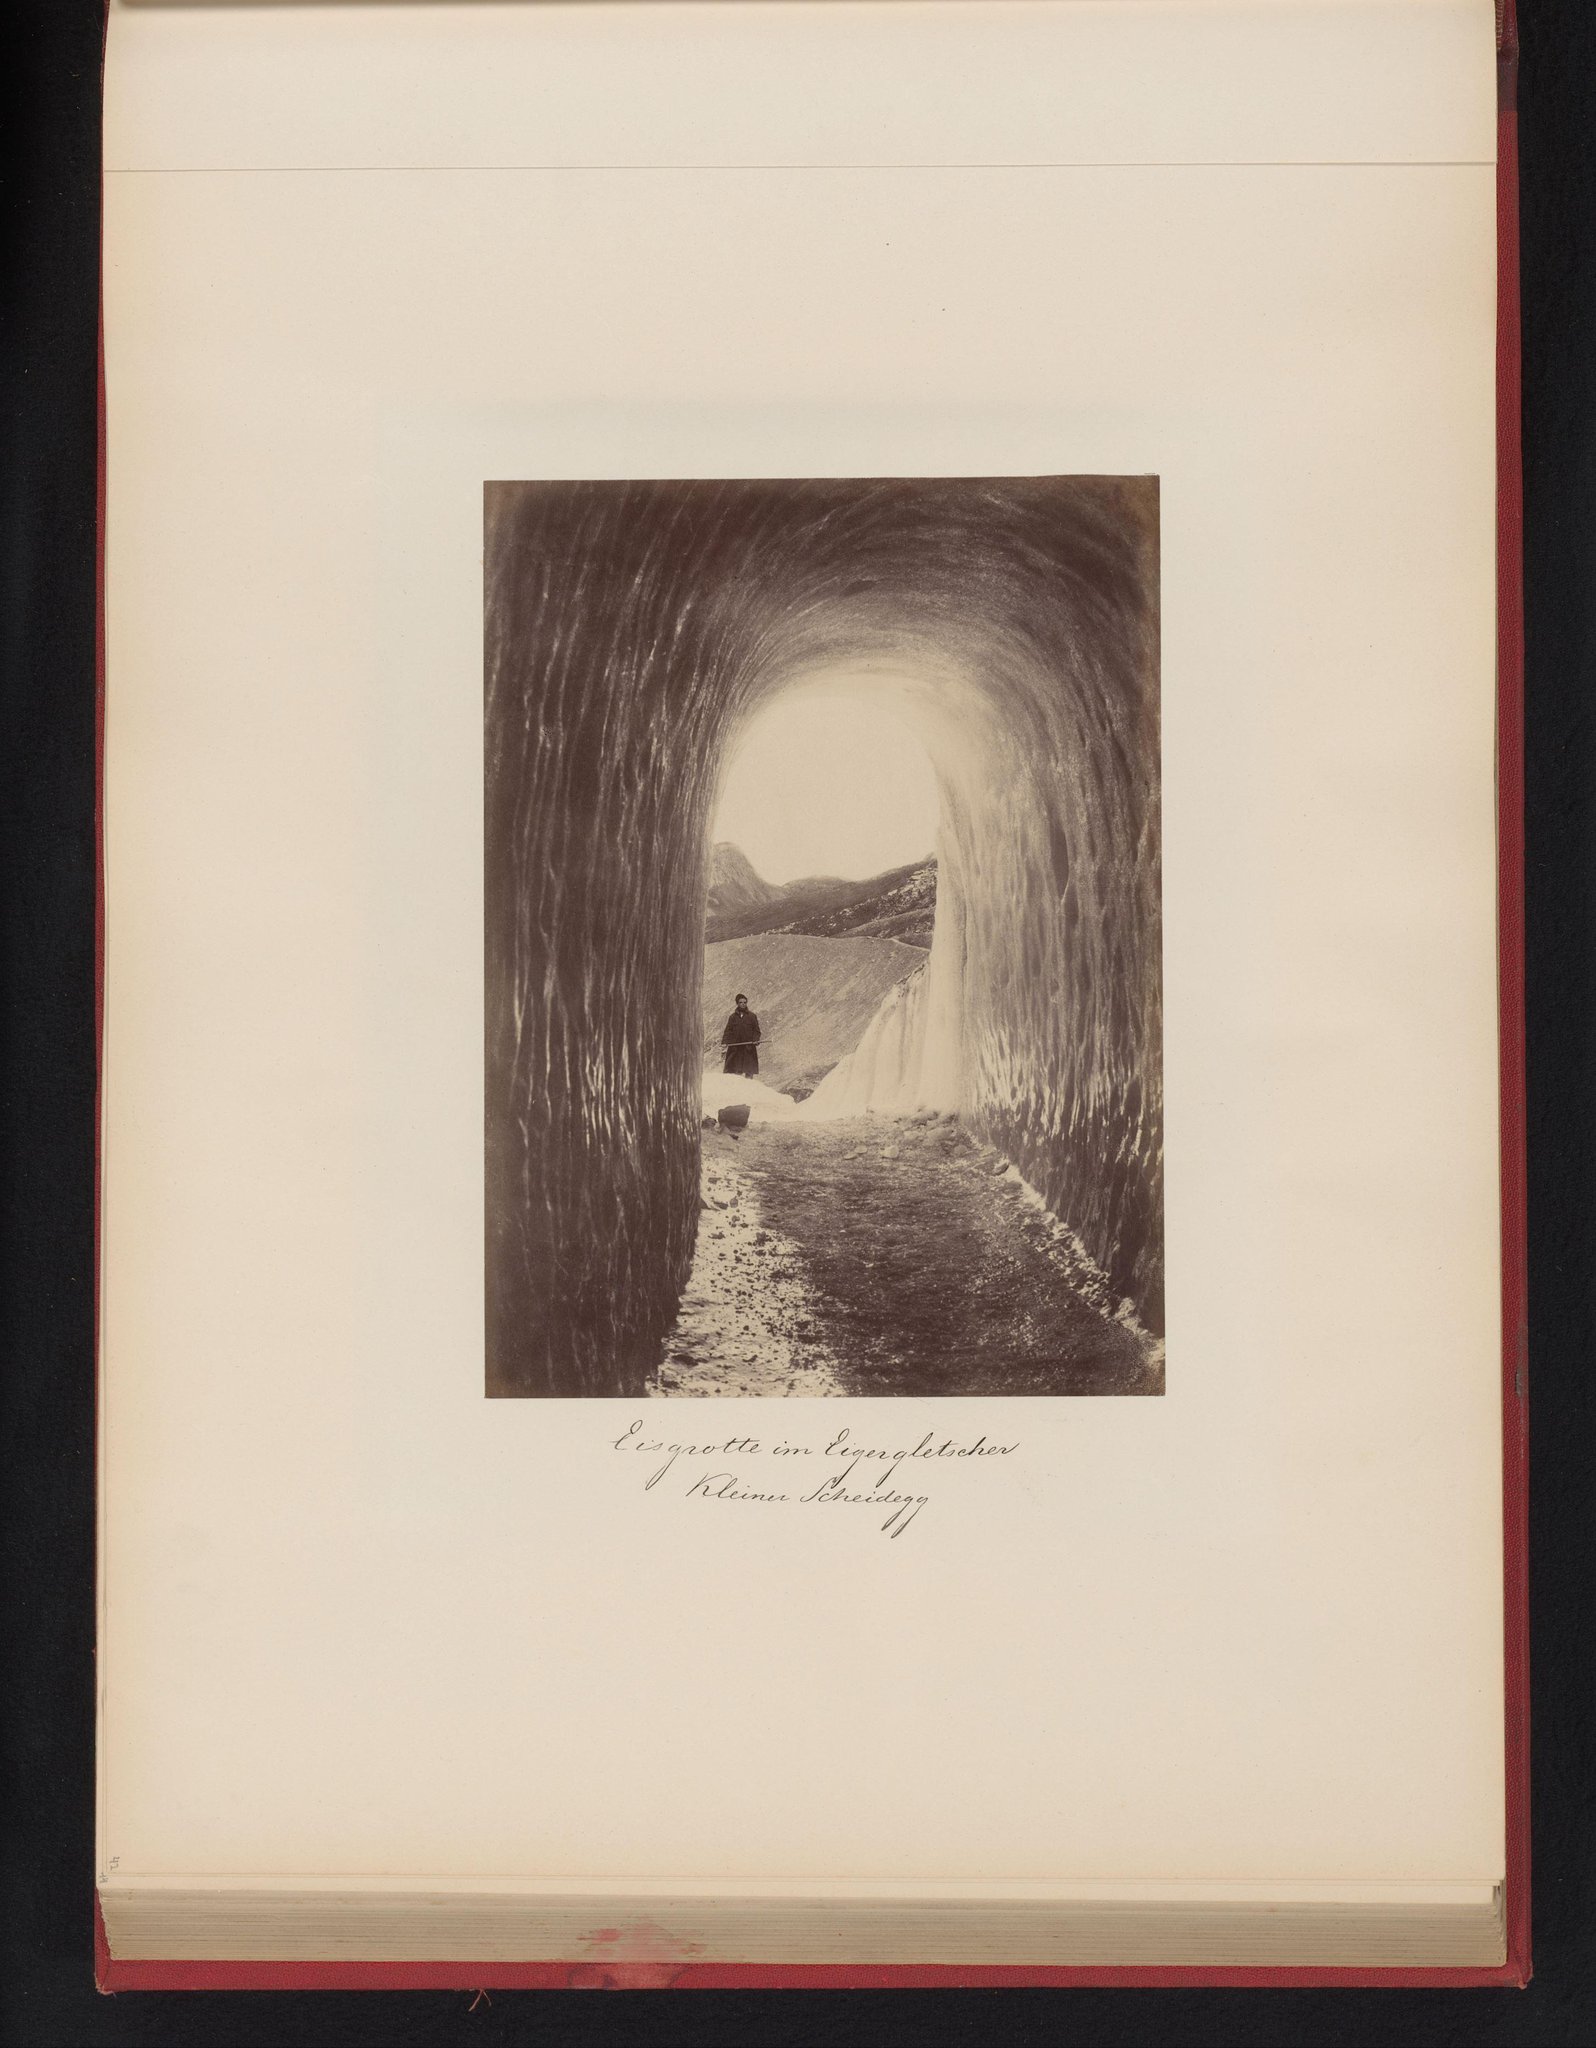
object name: album leaf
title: Interieur van een ijsgrot bij de Kleine Scheidegg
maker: Anonymous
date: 1880-1900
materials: photographic support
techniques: albumen print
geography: lauterbrunnen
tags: ice ~ state of water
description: Deze prent maakt deel uit van een album.